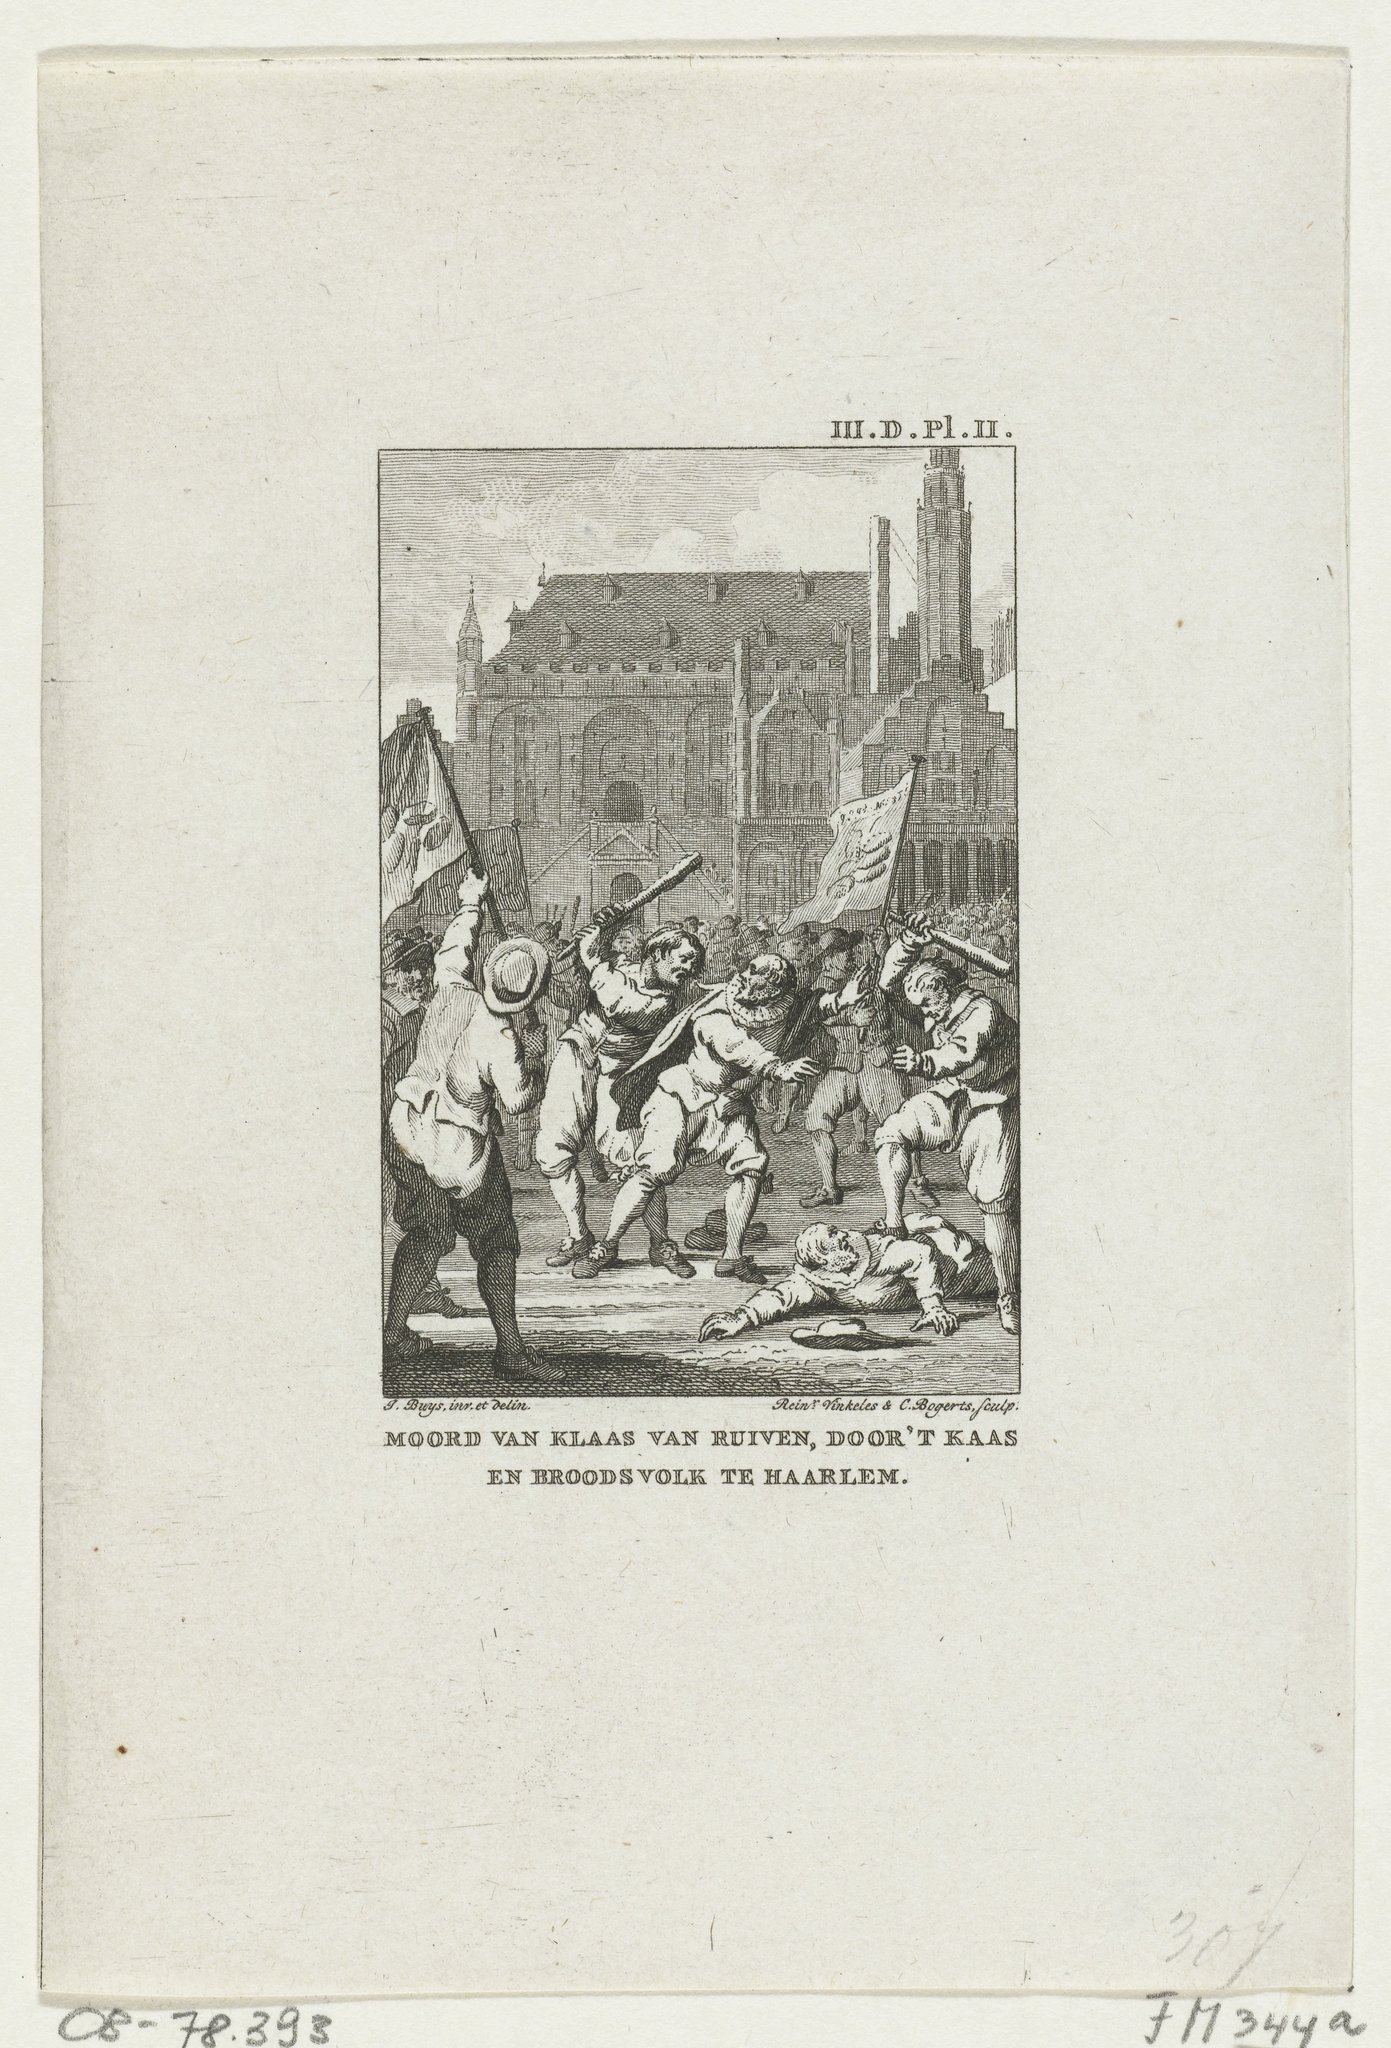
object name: print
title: Opstand van het Kaas- en Broodvolk en moord op Claes van Ruyven te Haarlem, 1492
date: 1780-1795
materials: paper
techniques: etching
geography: netherlands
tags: haarlem, violent death, being killed; being mishandled and maltreated; seeking death, street-fights, riots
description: Illustratie voor: J. Fokke, Geschiedenissen der Vereenigde Nederlanden voor de vaderlandsche jeugd, Johannes Allart, Amsterdam 1783-1795, 25 delen, dl. III, pl. II. Staat met de letter.